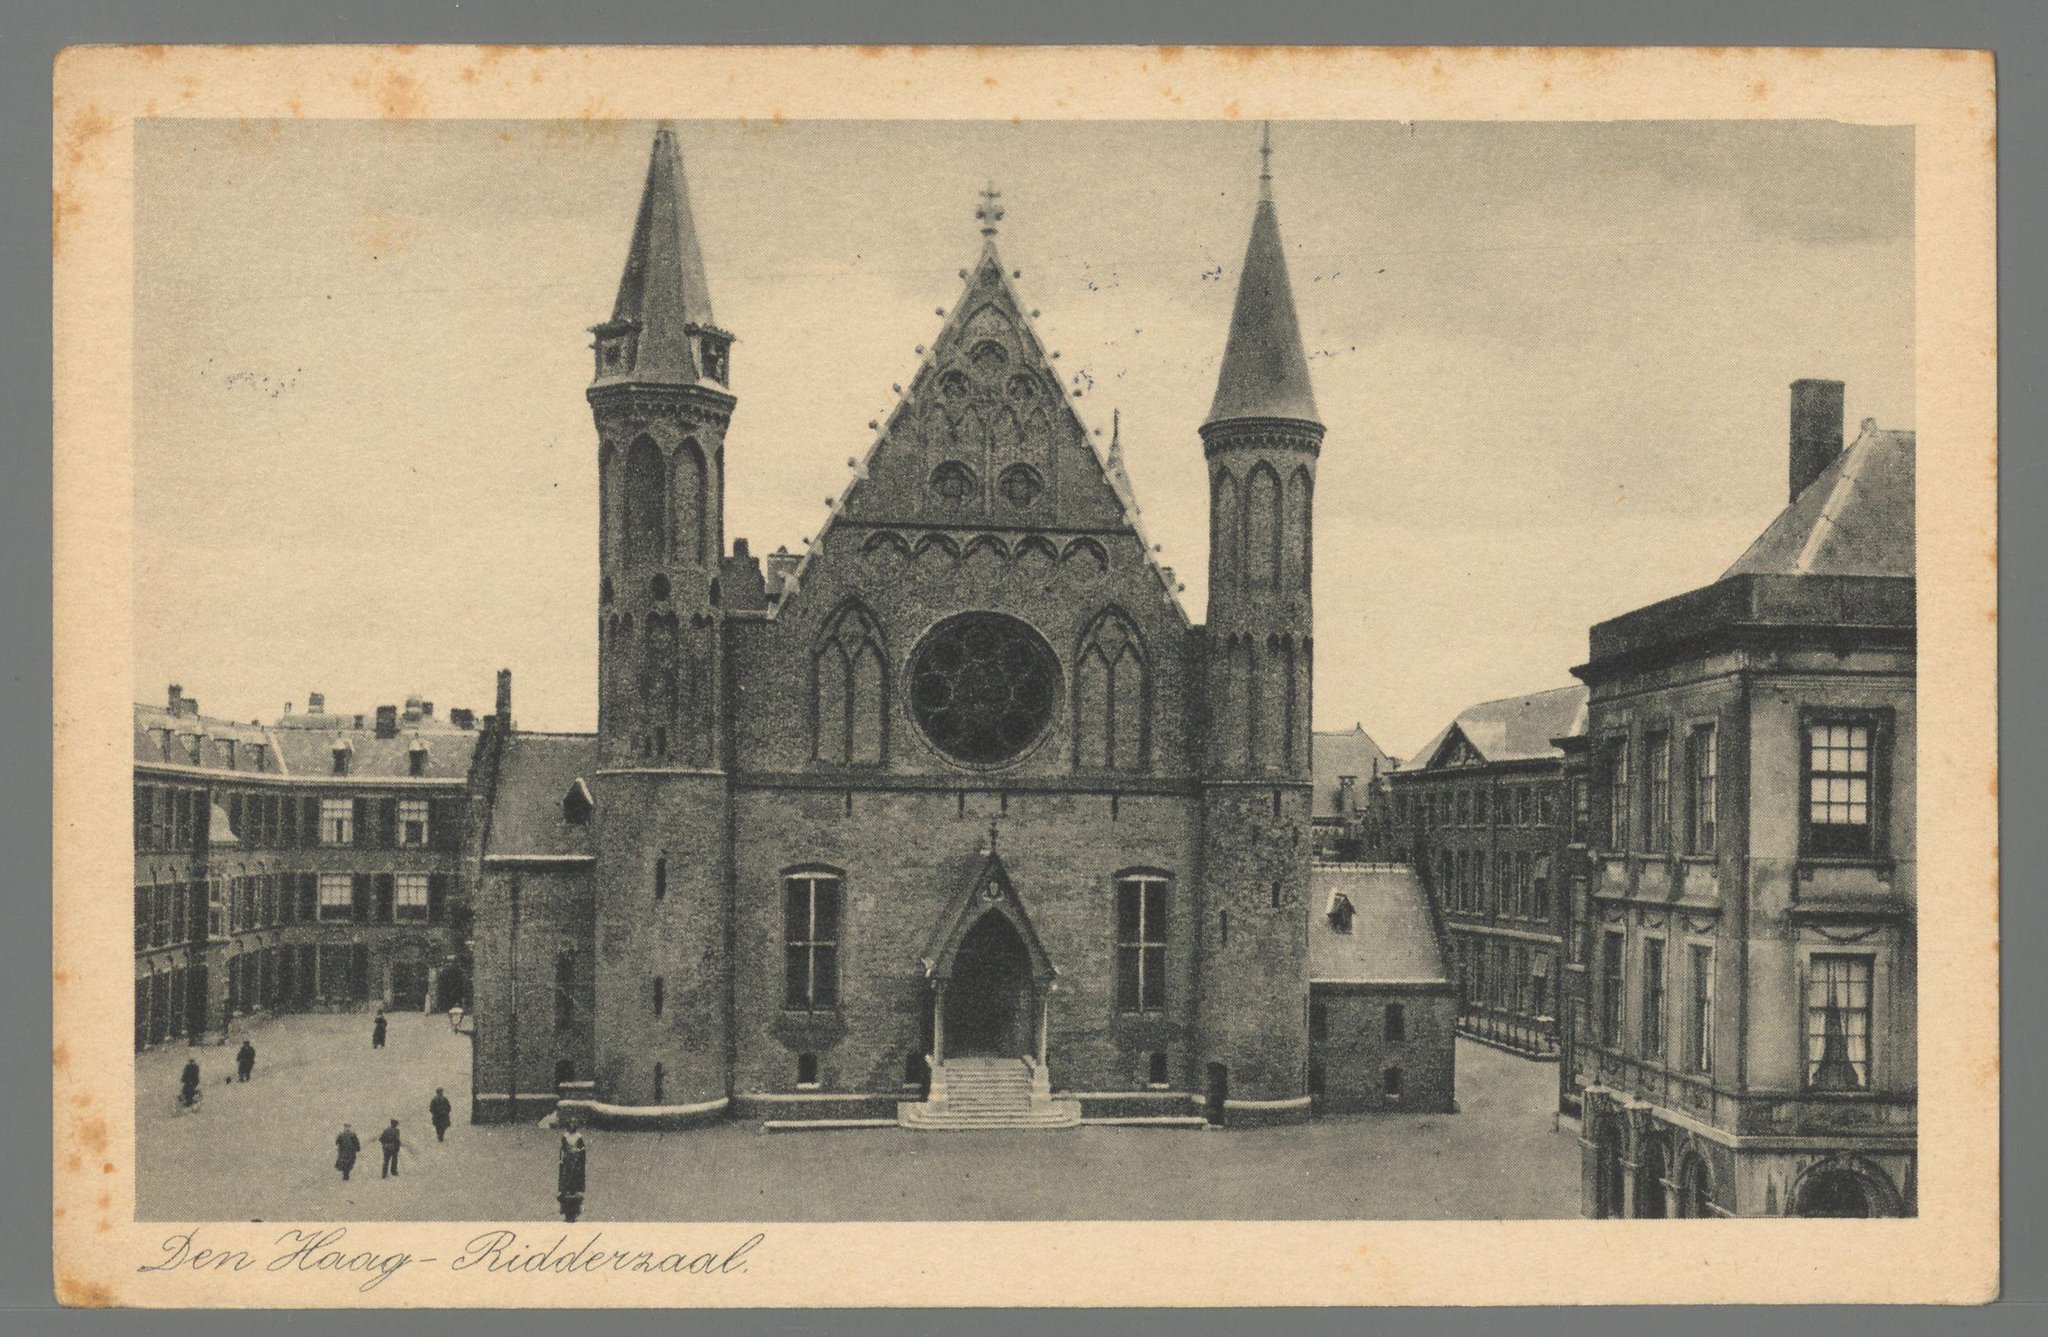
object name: ansichtkaart, prentbriefkaart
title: Den Haag - Ridderzaal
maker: Anonymous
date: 1927-1931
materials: cardboard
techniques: rotogravure, writing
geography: the hague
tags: city-view in general; 'veduta', village square, place, the hague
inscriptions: postage stamp